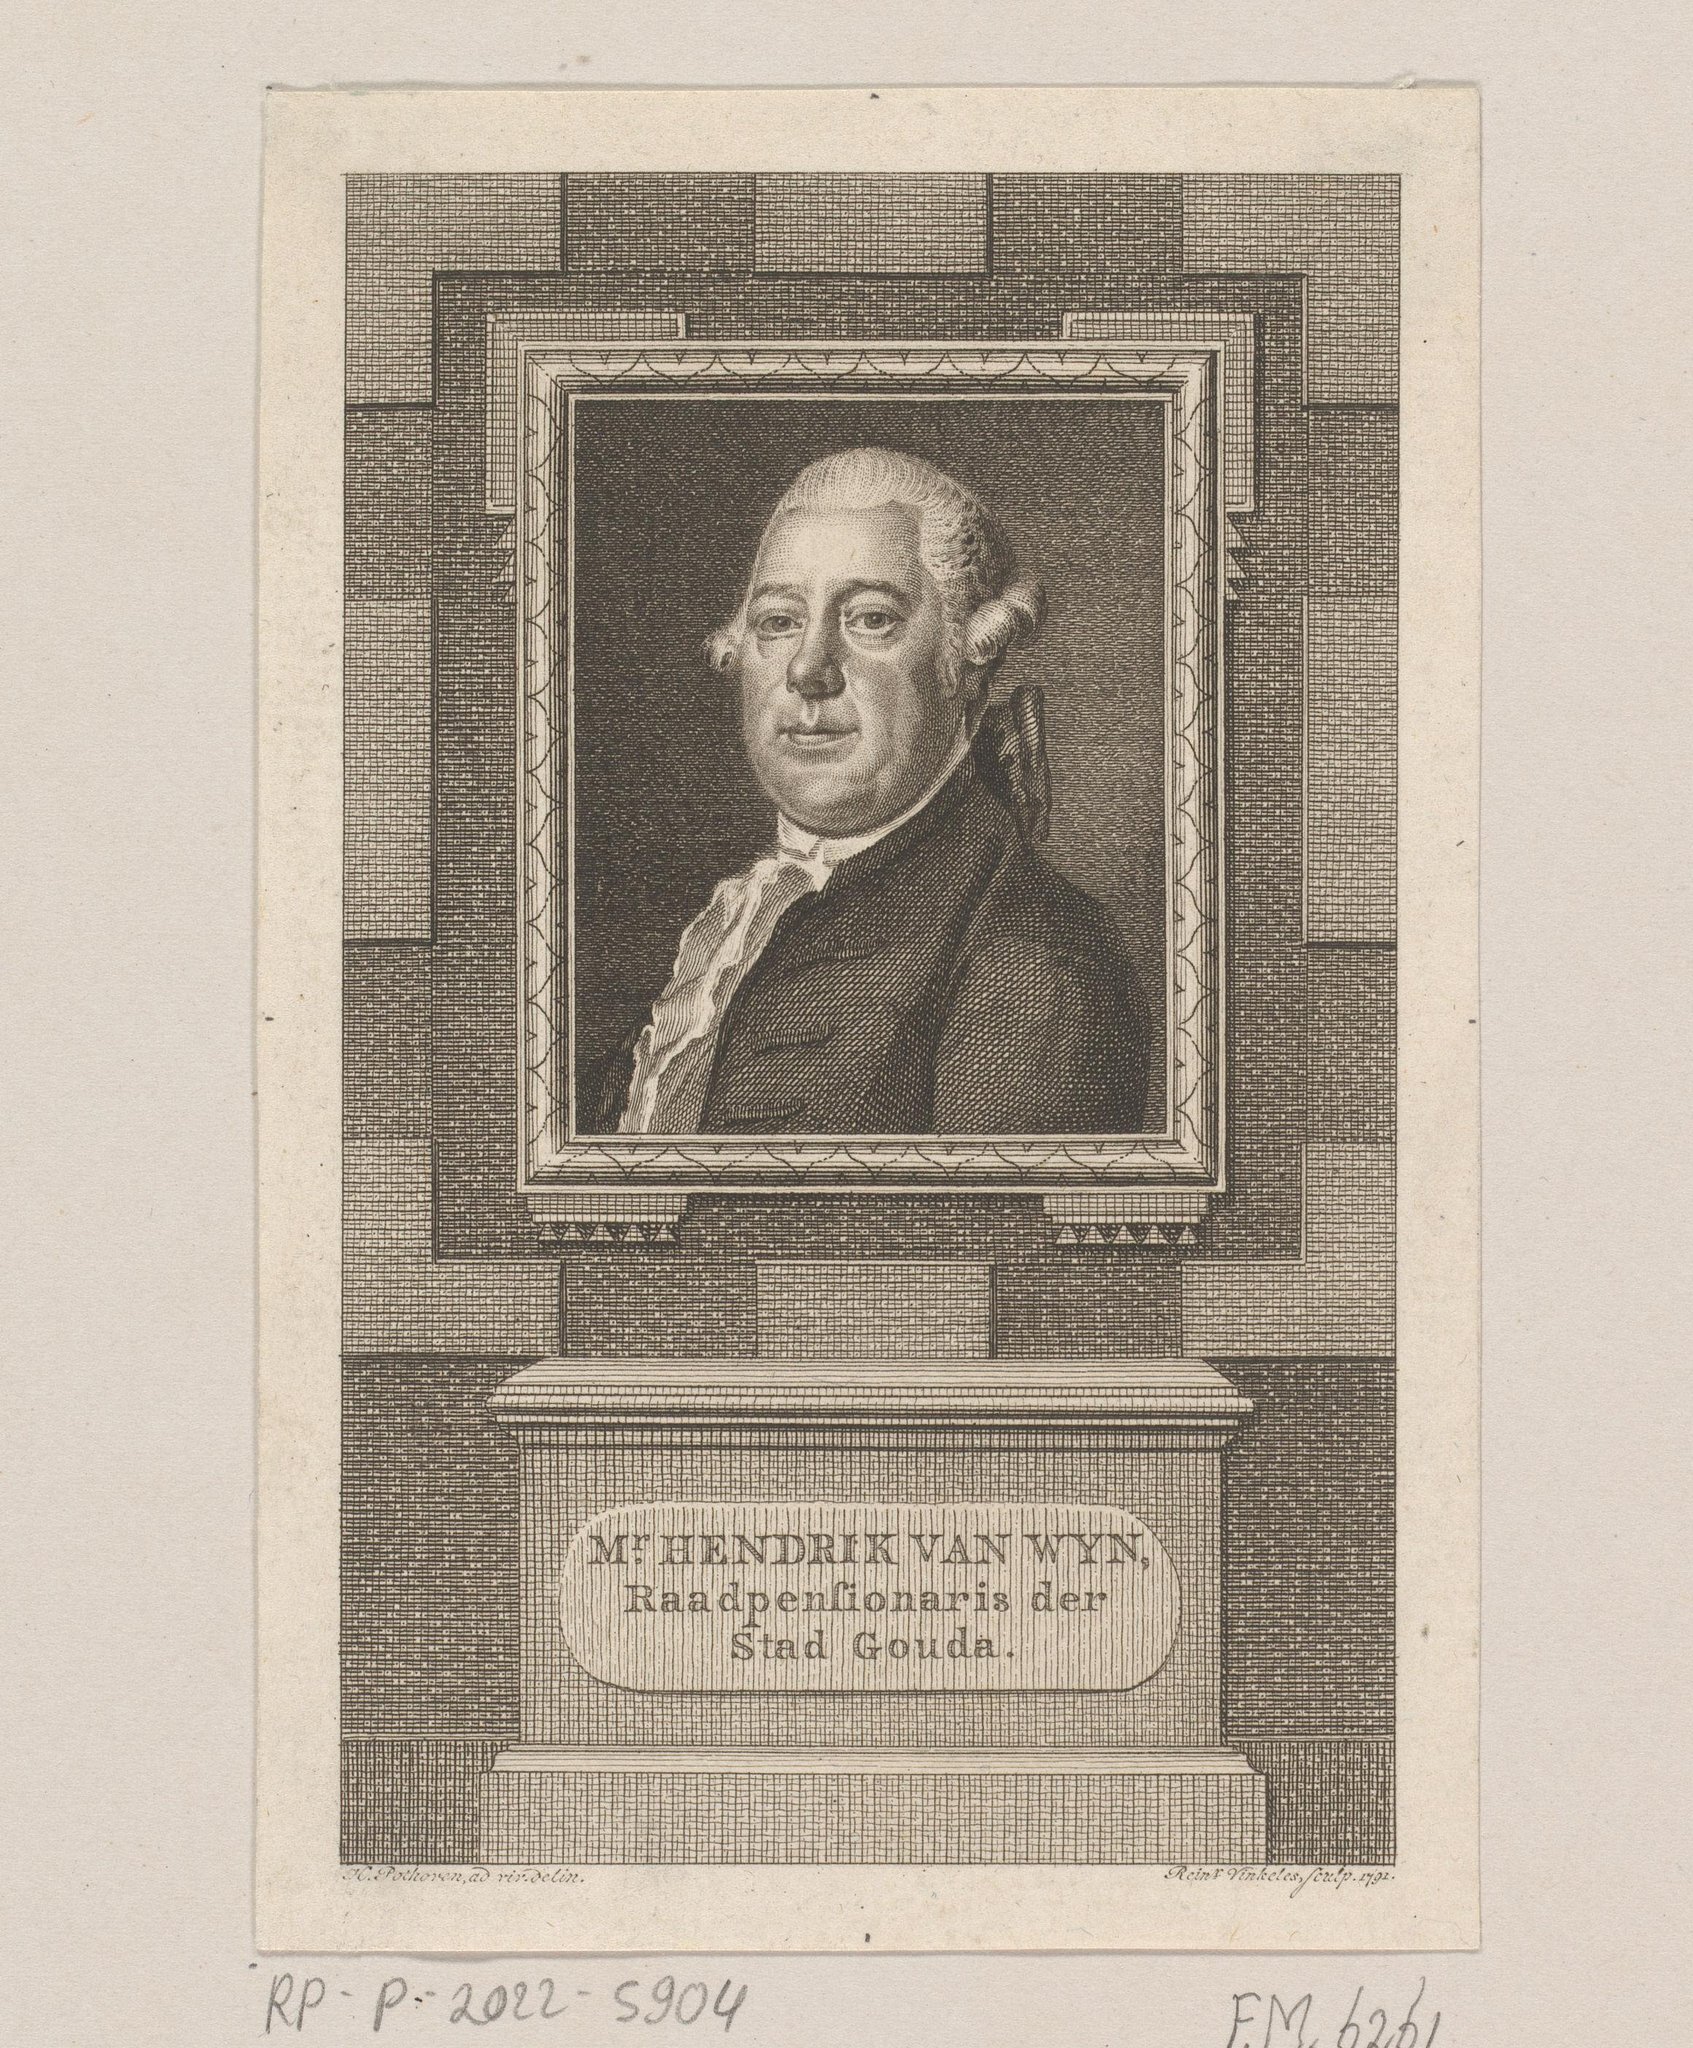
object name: book illustration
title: Portret van Hendrik van Wijn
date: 1791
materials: paper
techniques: engraving, etching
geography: amsterdam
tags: the hague, draughtsman, hendrik van wijn, historical persons, lawyer, attorney at law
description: Prent waarschijnlijk uit: Wagenaar, Jan. Vaderlandsche historie, vervattende de geschiedenissen der Vereenigde Nederlanden, (...). Amsterdam: Johannes Allart, 1791, dl. 6.